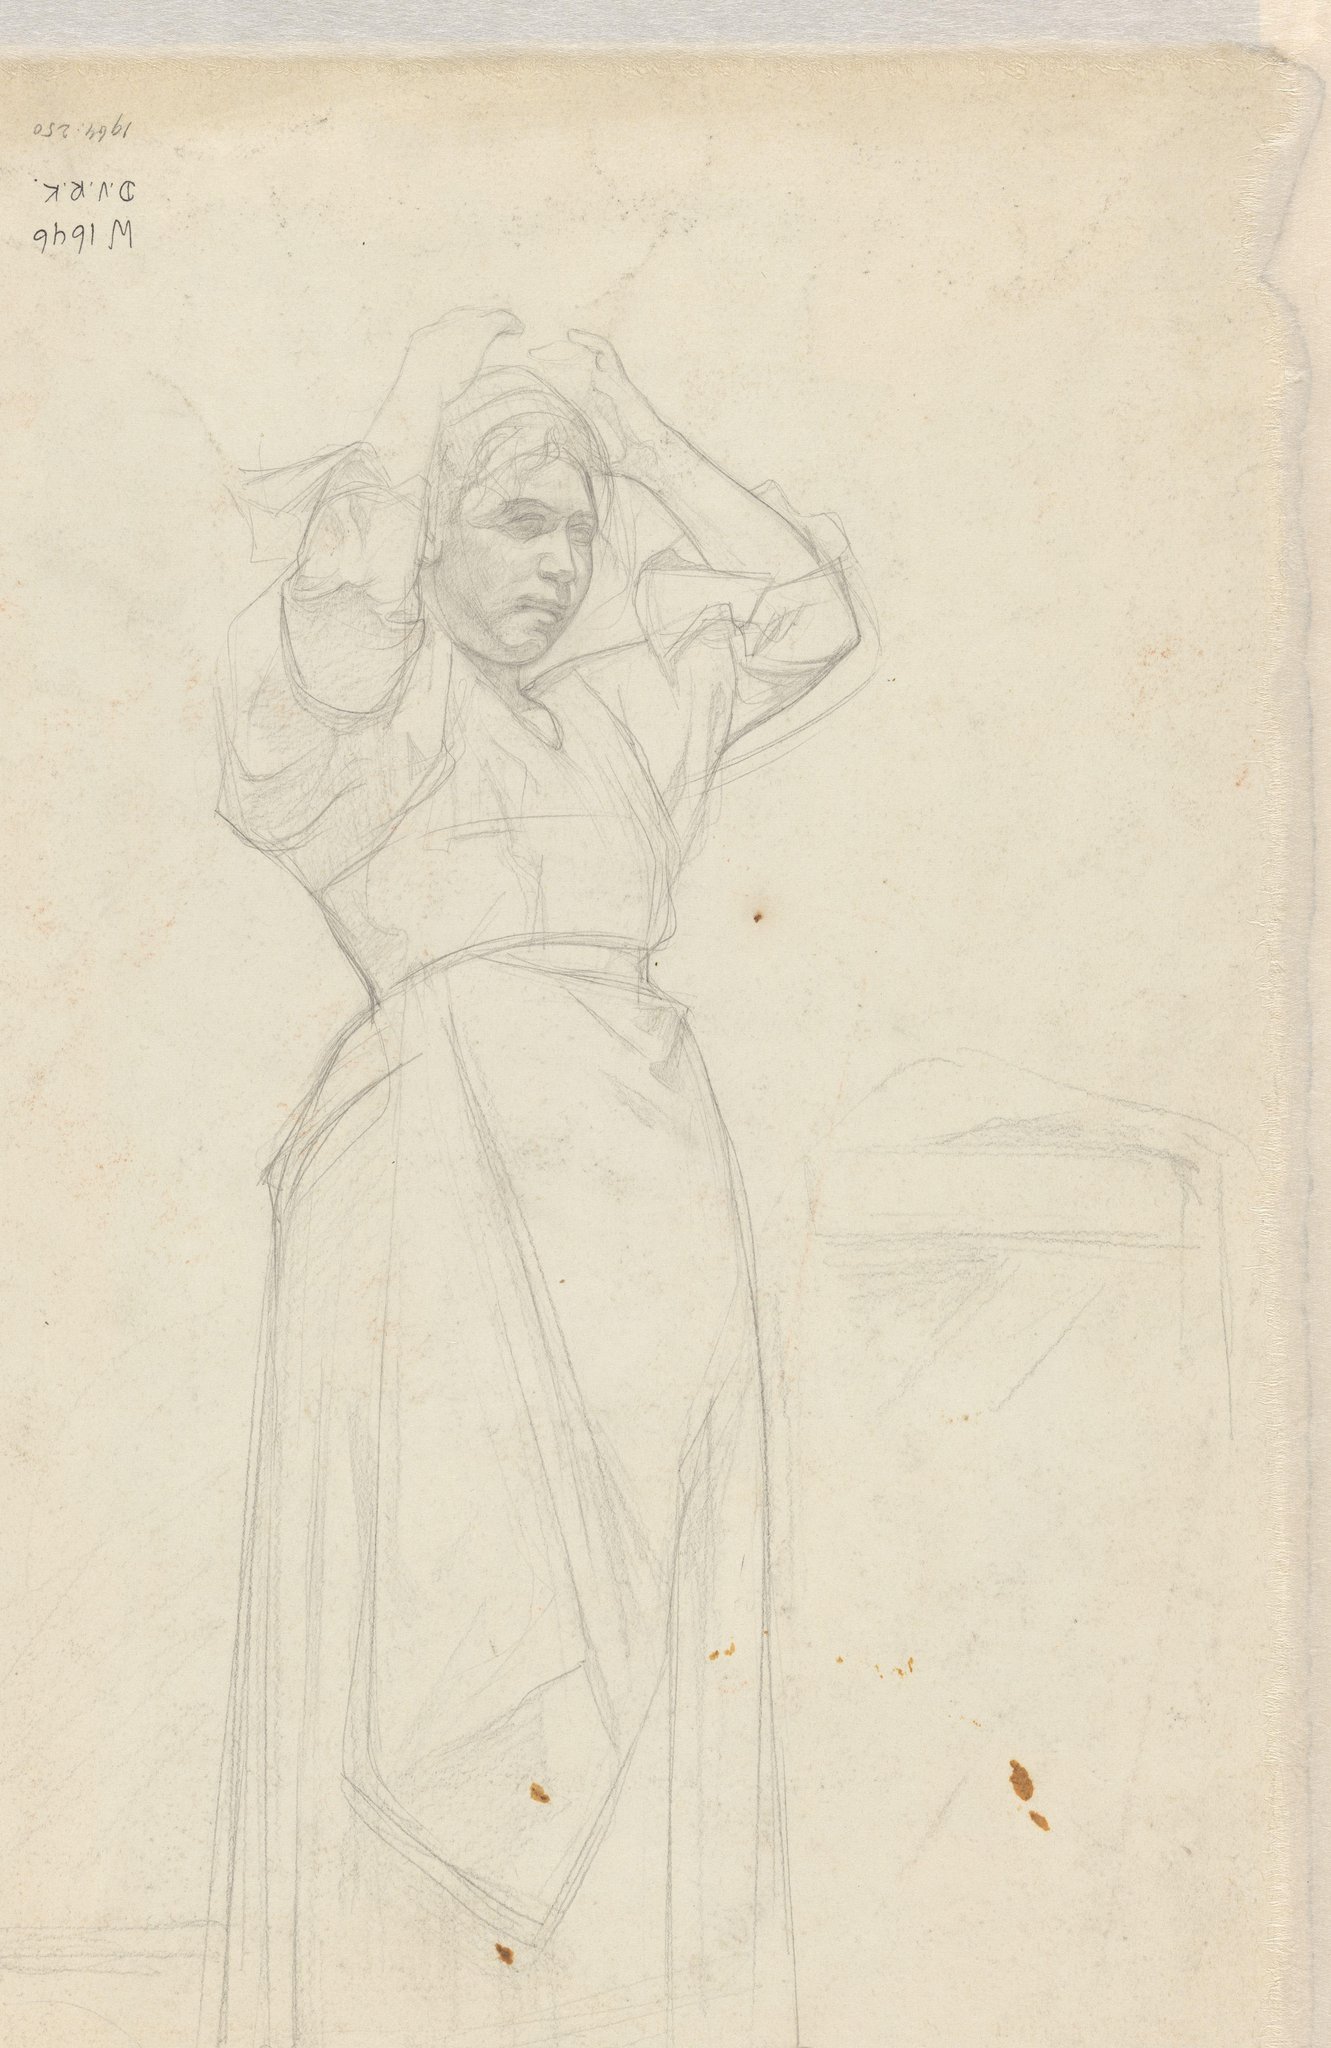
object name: drawing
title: Staande vrouw die het haar opmaakt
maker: willem witsen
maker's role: draughtsman, painter, print maker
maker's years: 1860-1923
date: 1870-1923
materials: paper, pencil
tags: making toilet - aa - (for) women